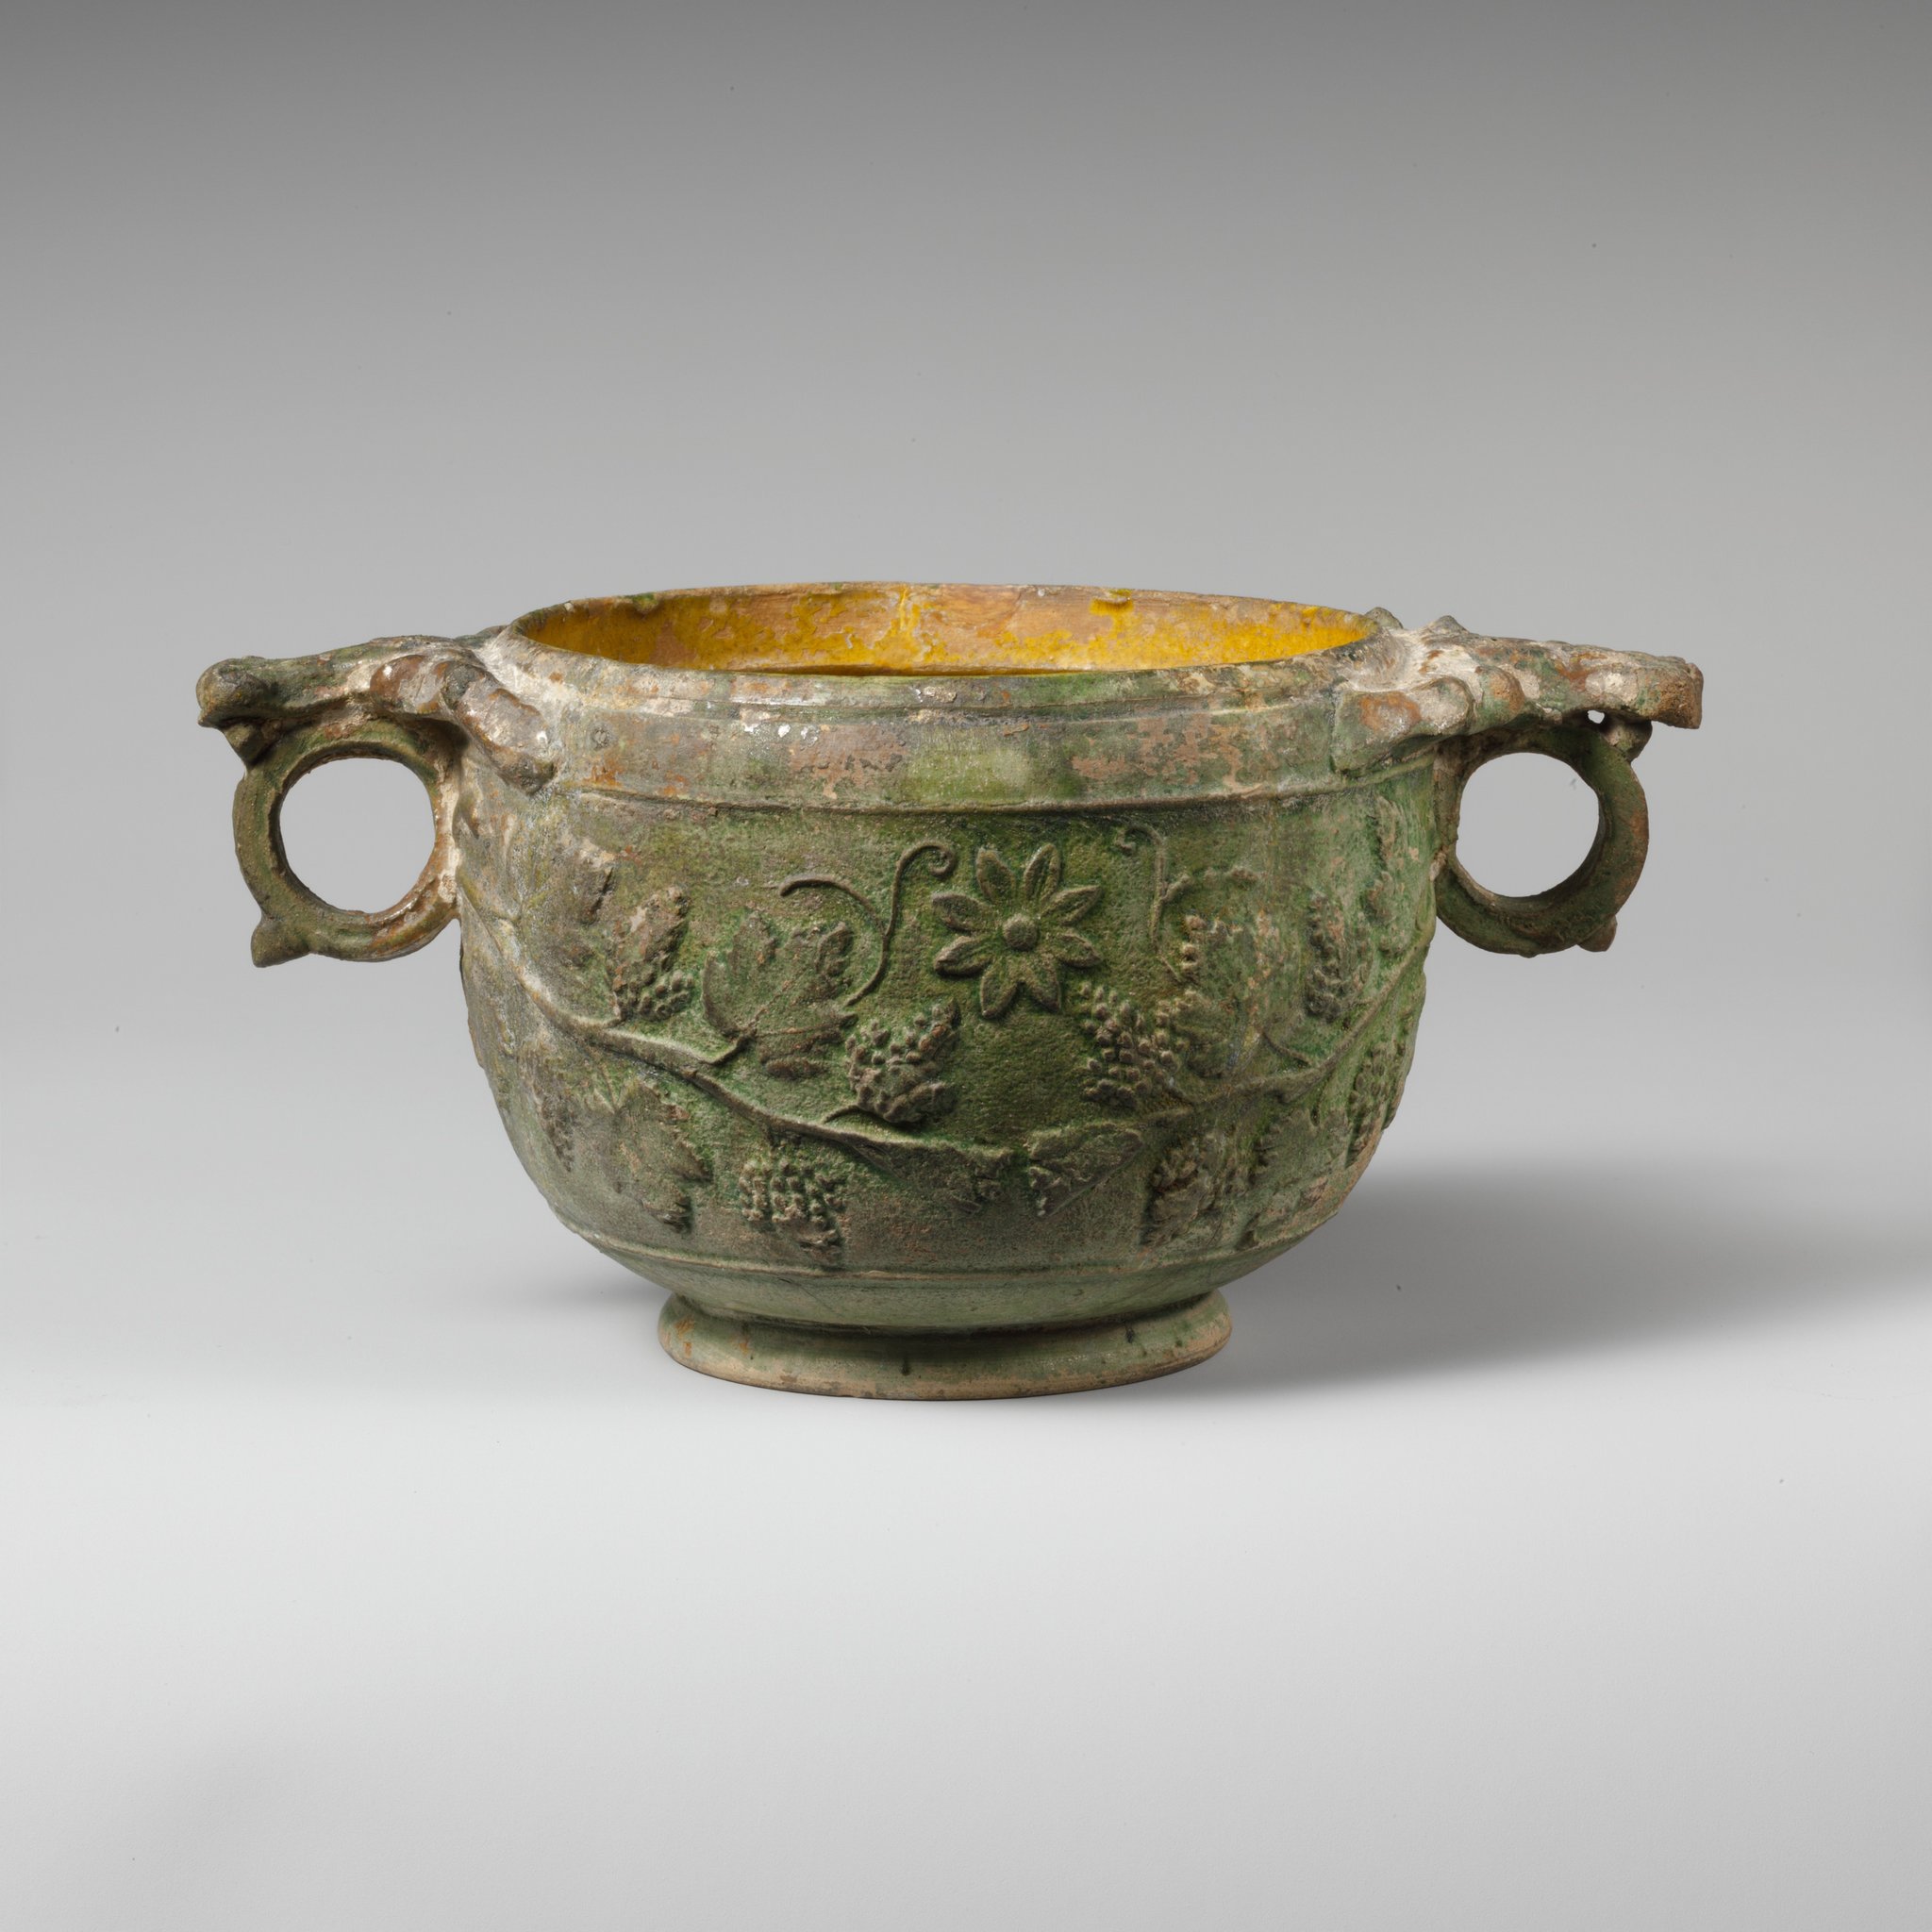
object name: skyphos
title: Terracotta scyphus (drinking cup)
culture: roman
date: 1-100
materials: terracotta